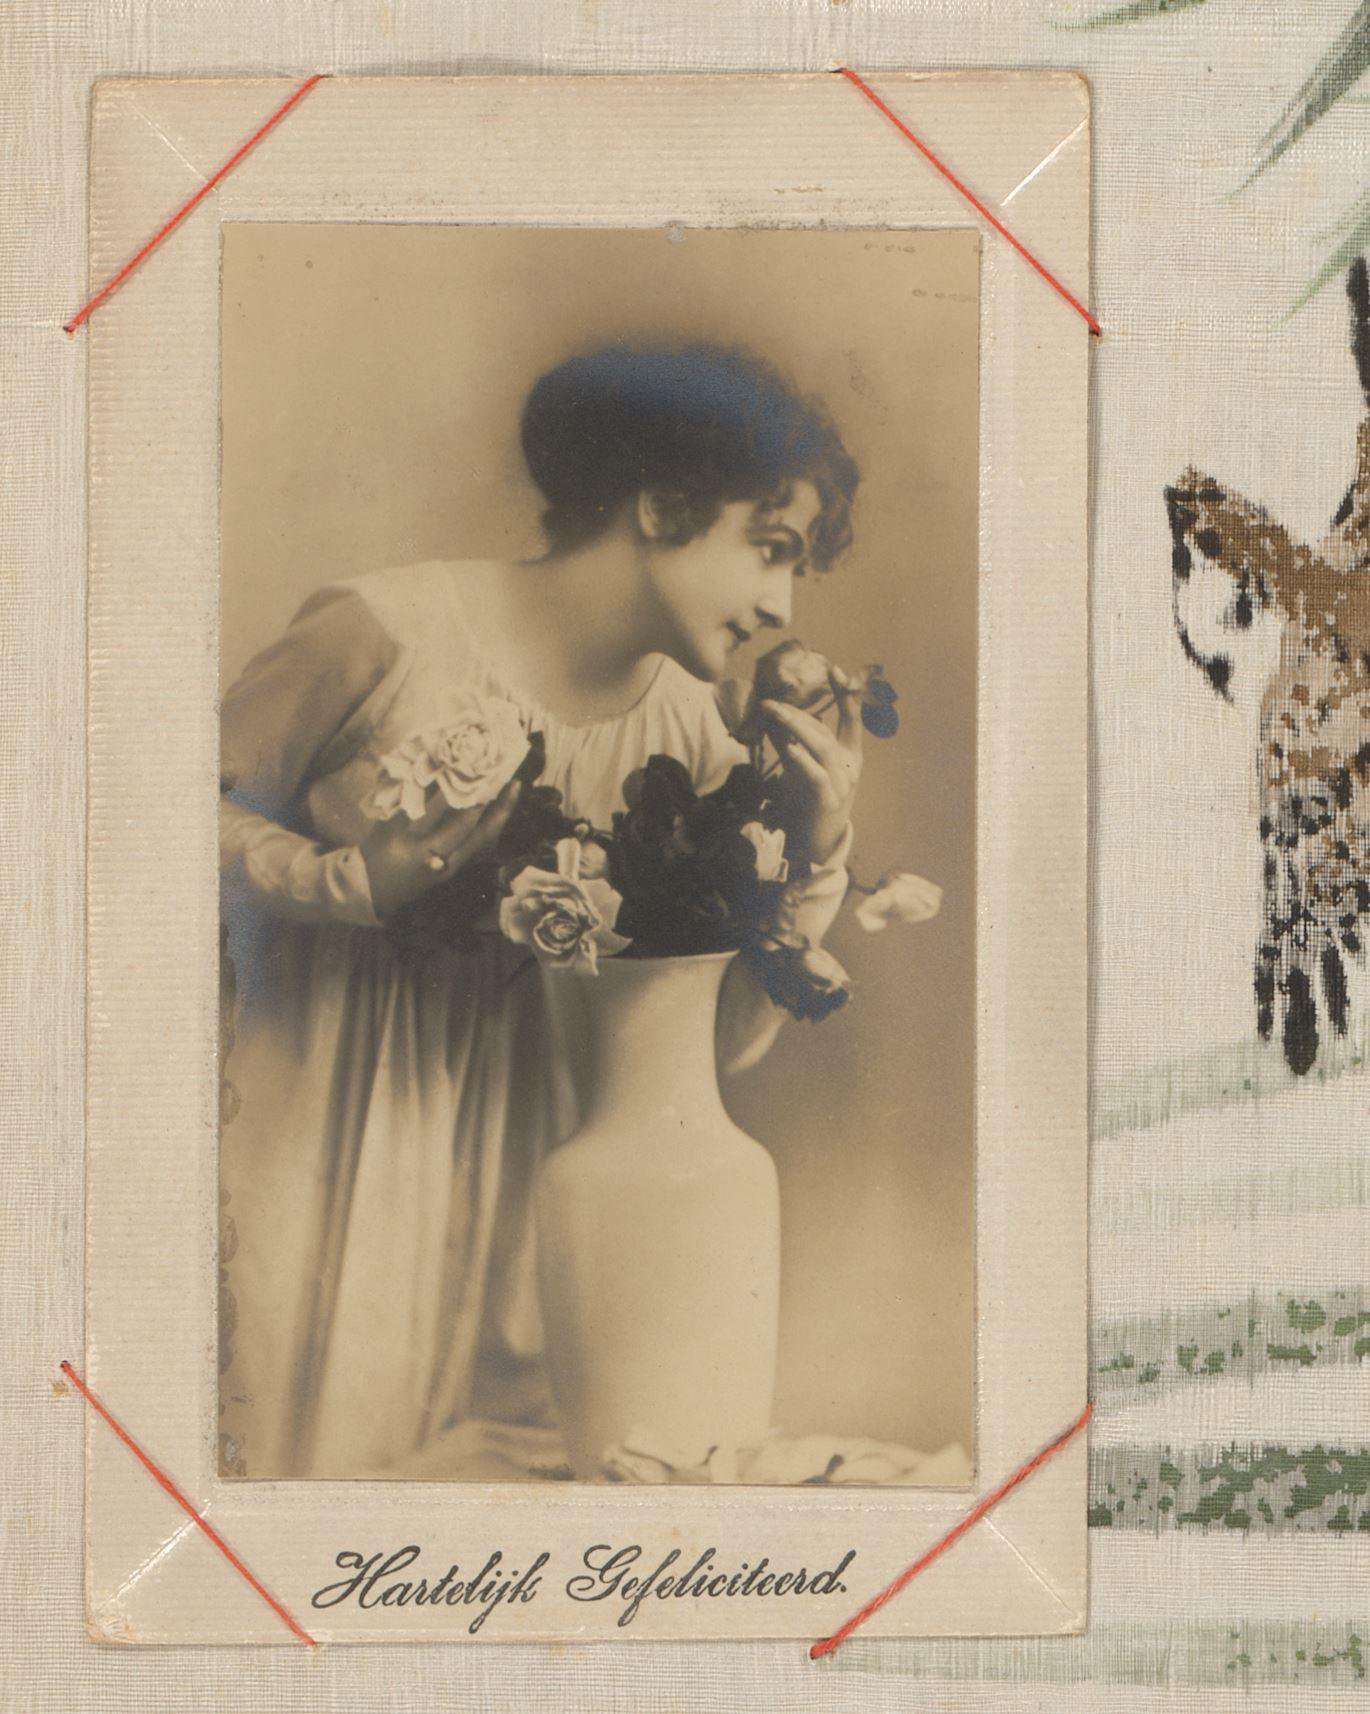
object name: photograph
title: Hartelijk Gefeliciteerd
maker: Anonymous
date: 1880-1920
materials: paint, photographic support, silk, textile, watercolor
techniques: brush, gelatin silver print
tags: flowers, adult woman, historical persons